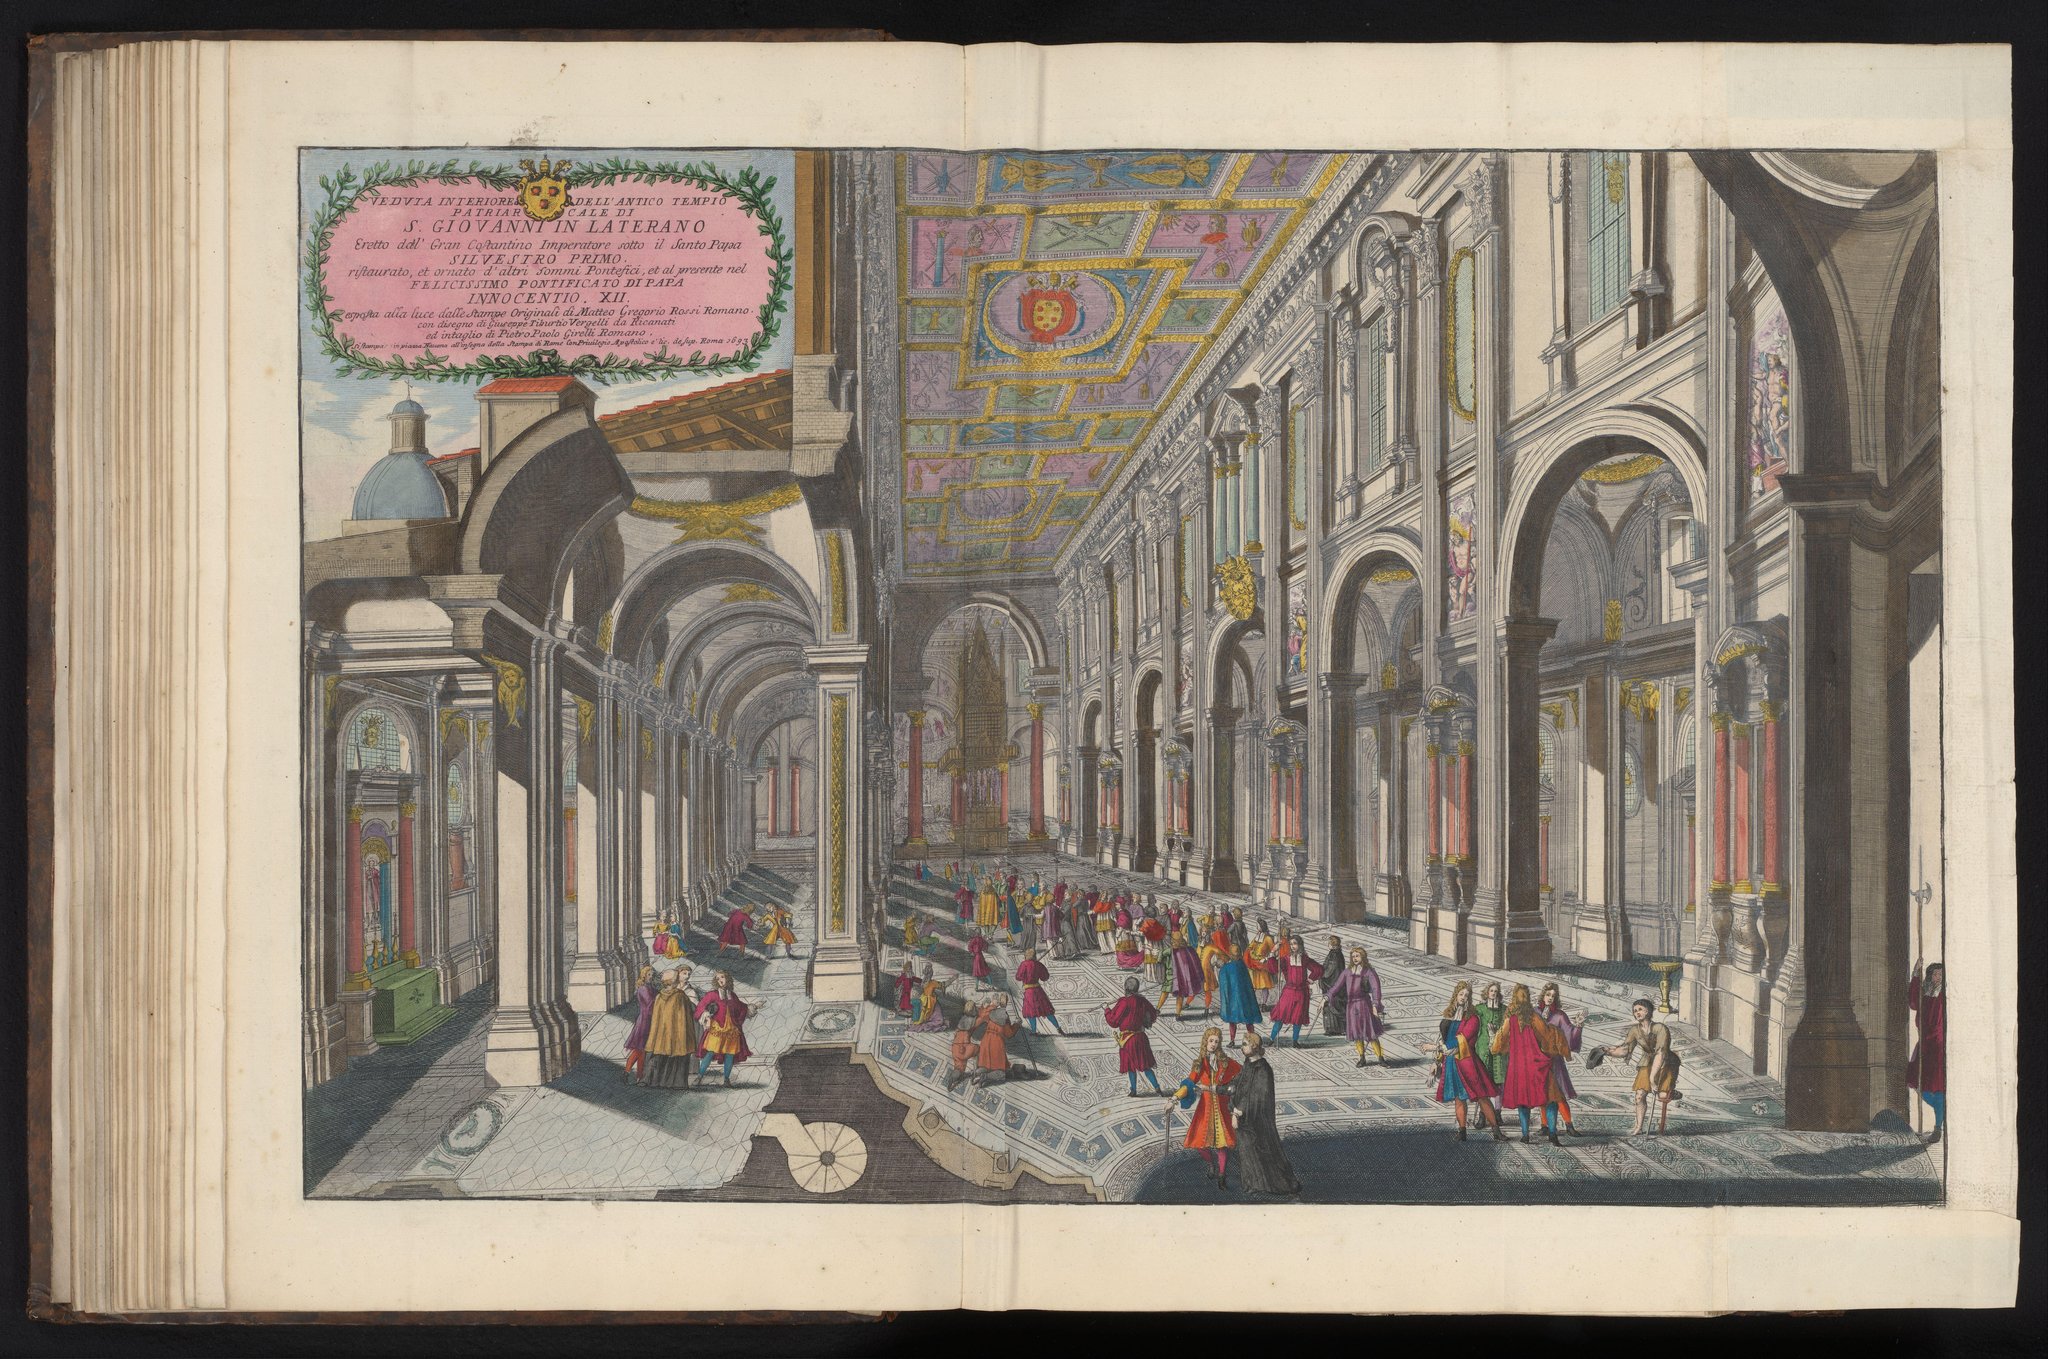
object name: print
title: Conspectus areae sacrosanctae Basilicae Lateranensis (...)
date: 1693-1717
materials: paper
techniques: colour, etching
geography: rome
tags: interior of church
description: Gezicht in het interieur van de Sint-Jan van Lateranen te Rome. Linksboven een cartouche met titel en tekst in het Latijn. Prent maakt deel uit van een album.